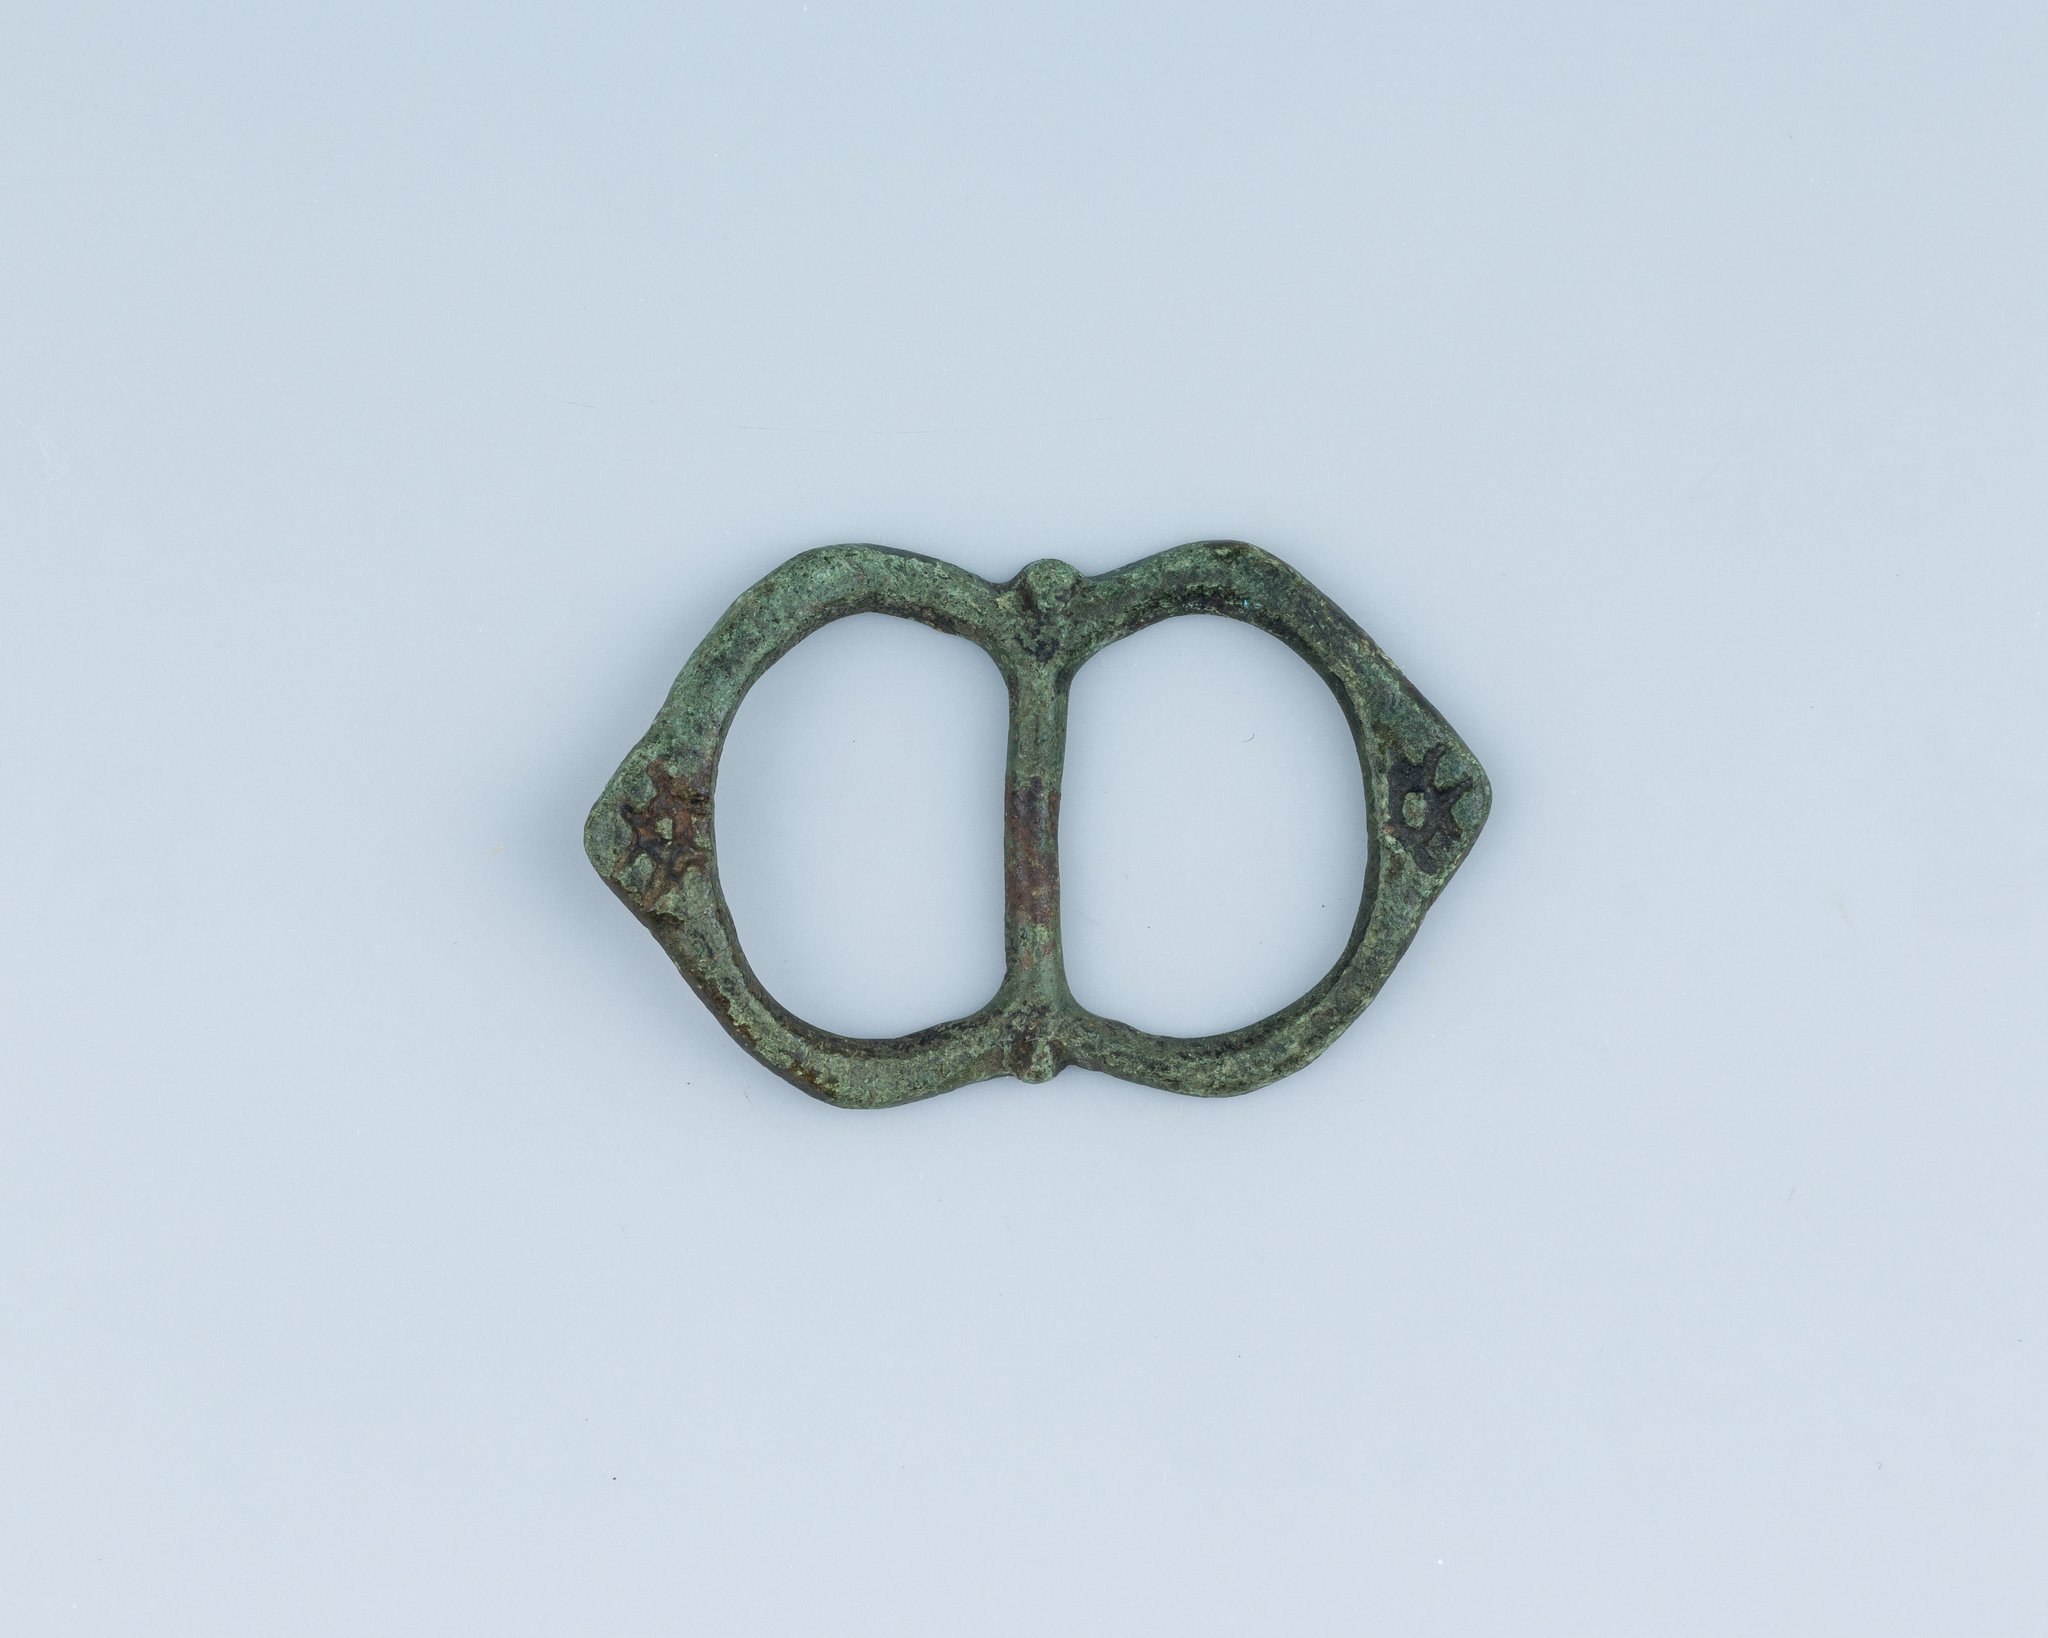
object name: buckle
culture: european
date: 1401-1600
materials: bronze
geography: germany